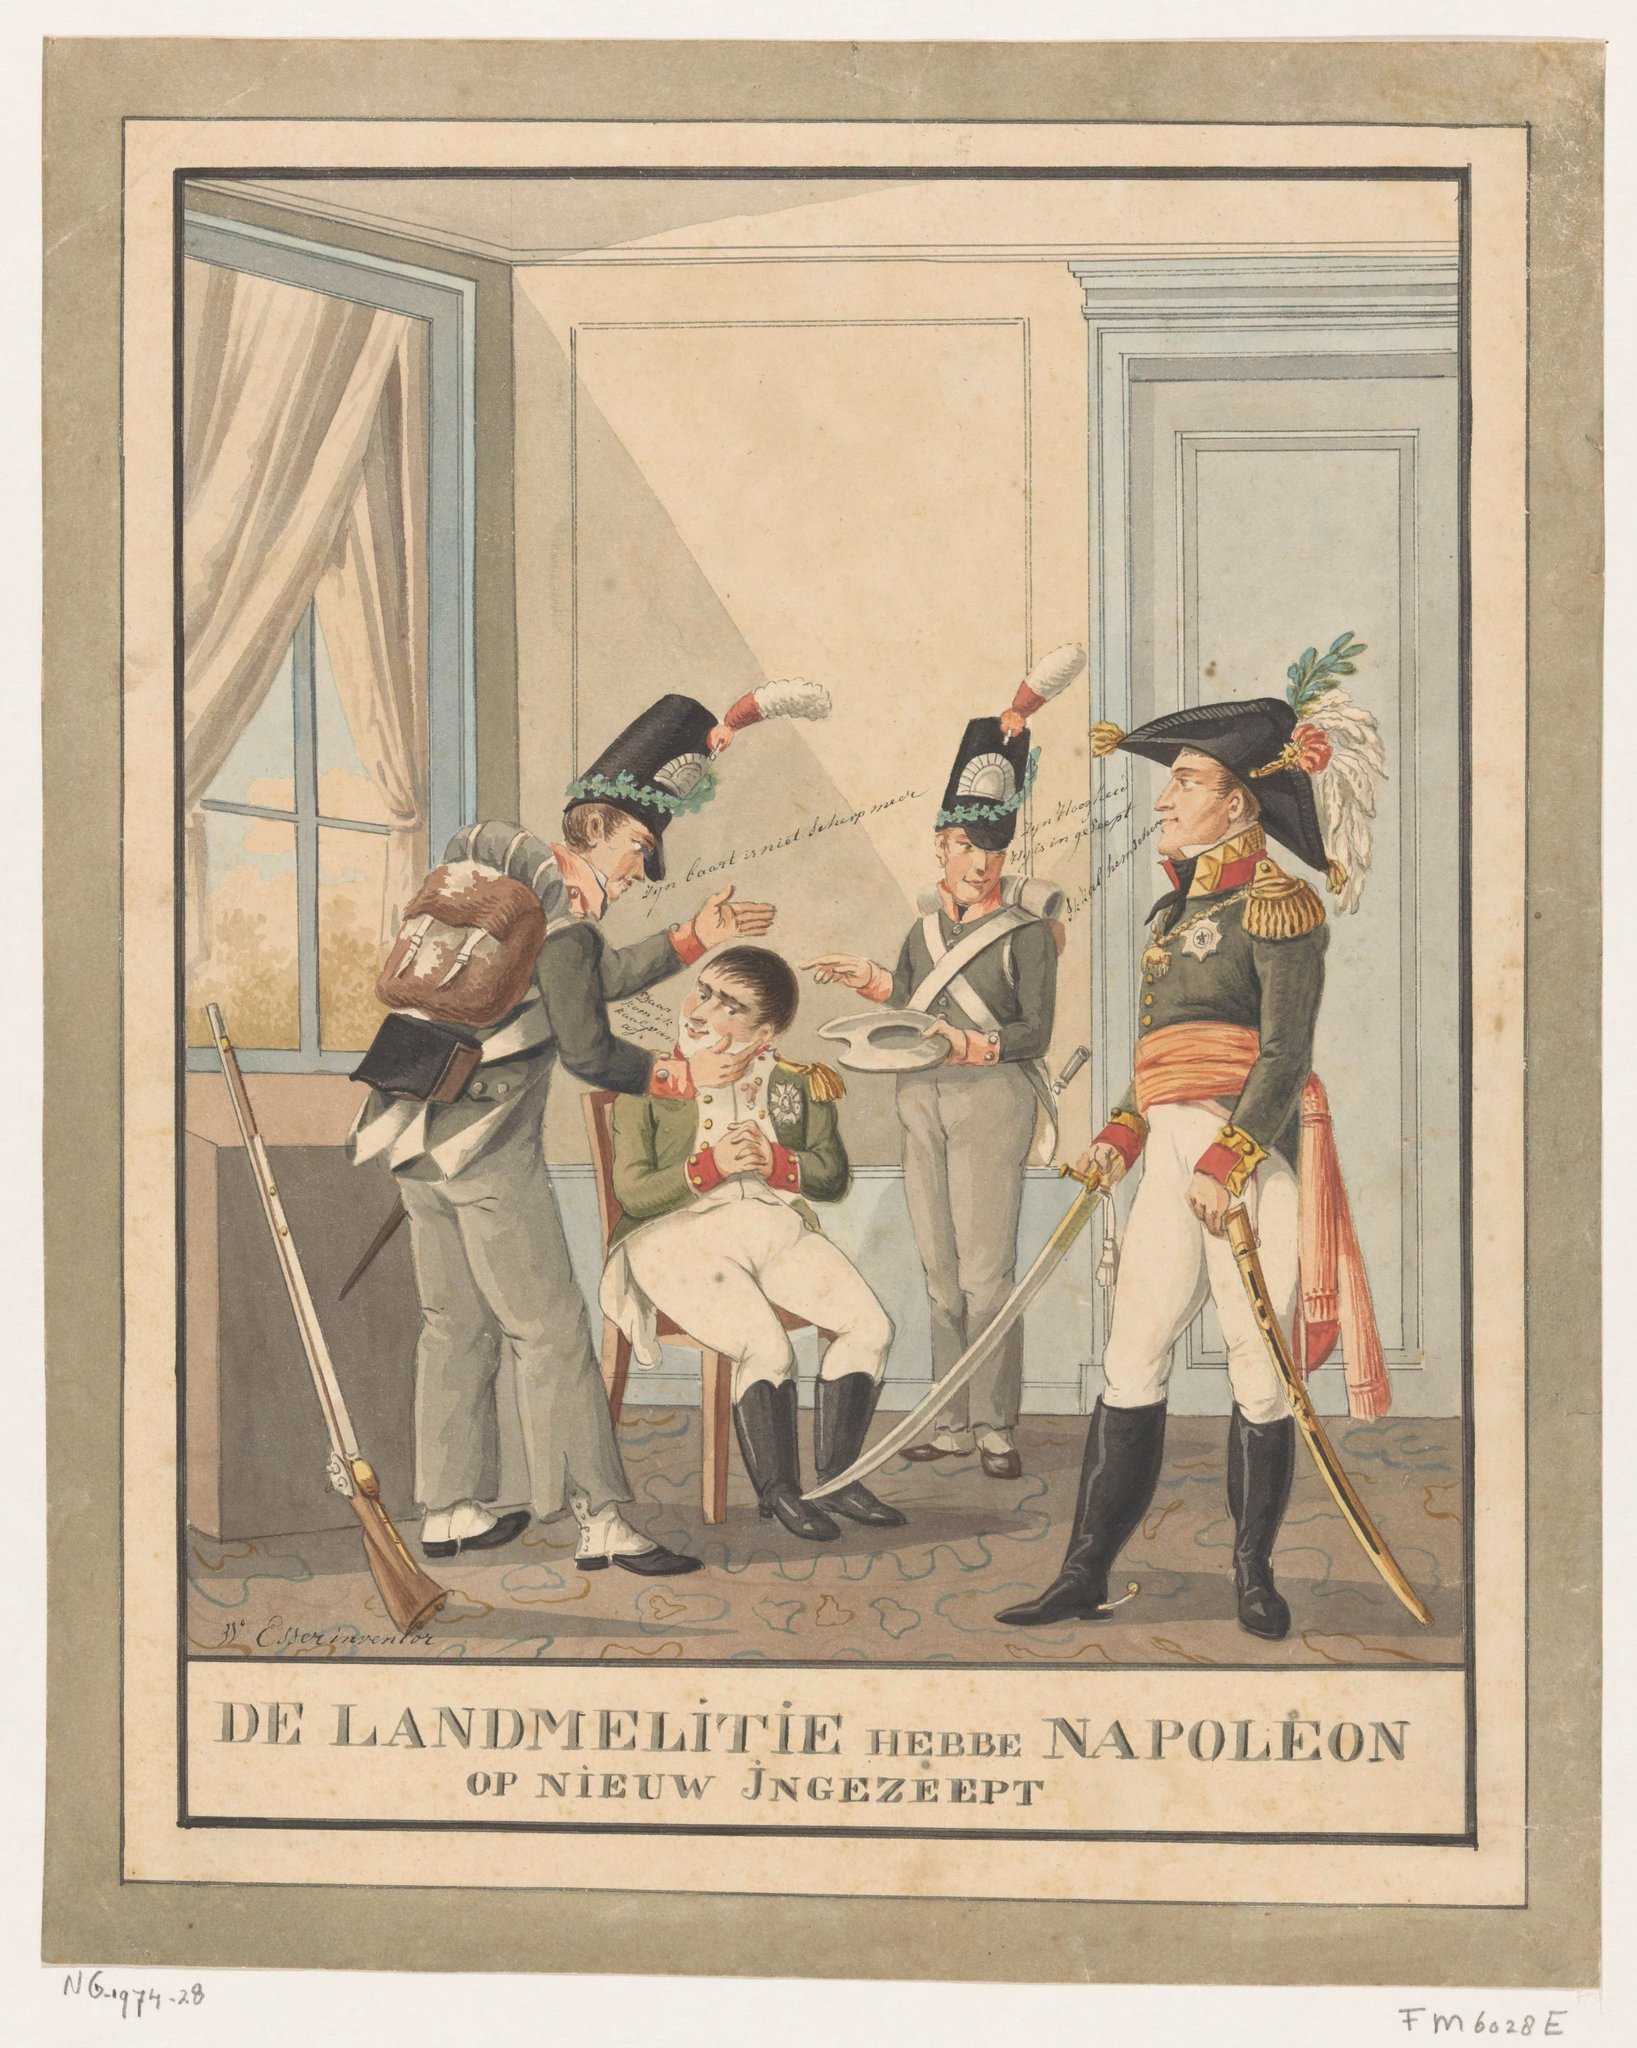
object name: cartoon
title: Napoleon wordt geschoren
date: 1815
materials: paper, watercolor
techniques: brush, pen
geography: netherlands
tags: napoleon i (emperor of the french), shaving, being shaved, political caricatures and satires, waterloo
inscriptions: inscription: ‘Zijn baard is niet scherp meer / [Napoleon:] 'Daar kom ik kaal van af' / Zijn Hoogheid Hy is ingeseept / Ik zal hem schere’, inscription: ‘bij W. Esser Kunstkooper / in de Spuy straat Letter S no 31 / a 'sGraavenhaage / 1815’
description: Spotprent waarin Napoleon wordt geschoren door militairen van de Nederlandse landmilitie, 1815. In een interieur smeert een militair met de rechterhand zeep op de kaken van Napoleon, zittend op een stoel met de handen gevouwen op de buik, terwijl een andere militair in de linkerhand het scheerbekken vasthoudt. Rechts een staande officier met getrokken zwaard in de rechterhand klaar om te scheren.